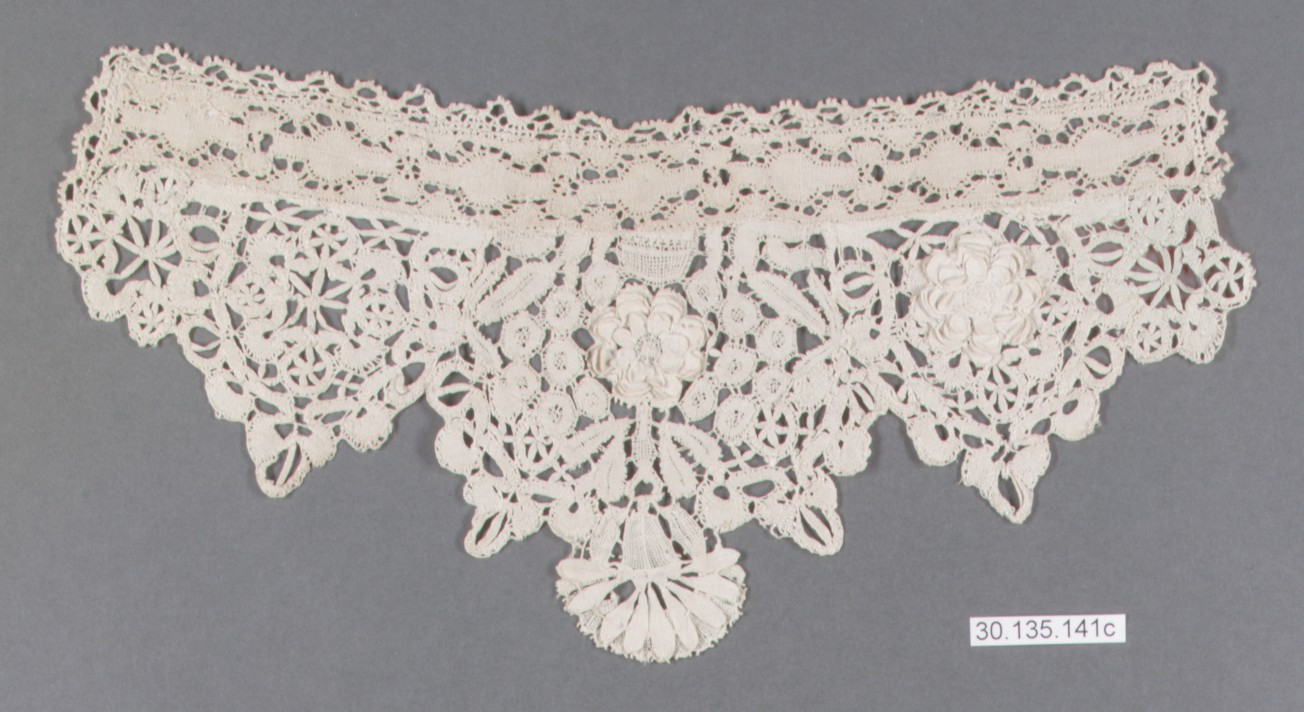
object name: cuff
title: Cuff (one of a pair)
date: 1850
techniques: lace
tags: flowers